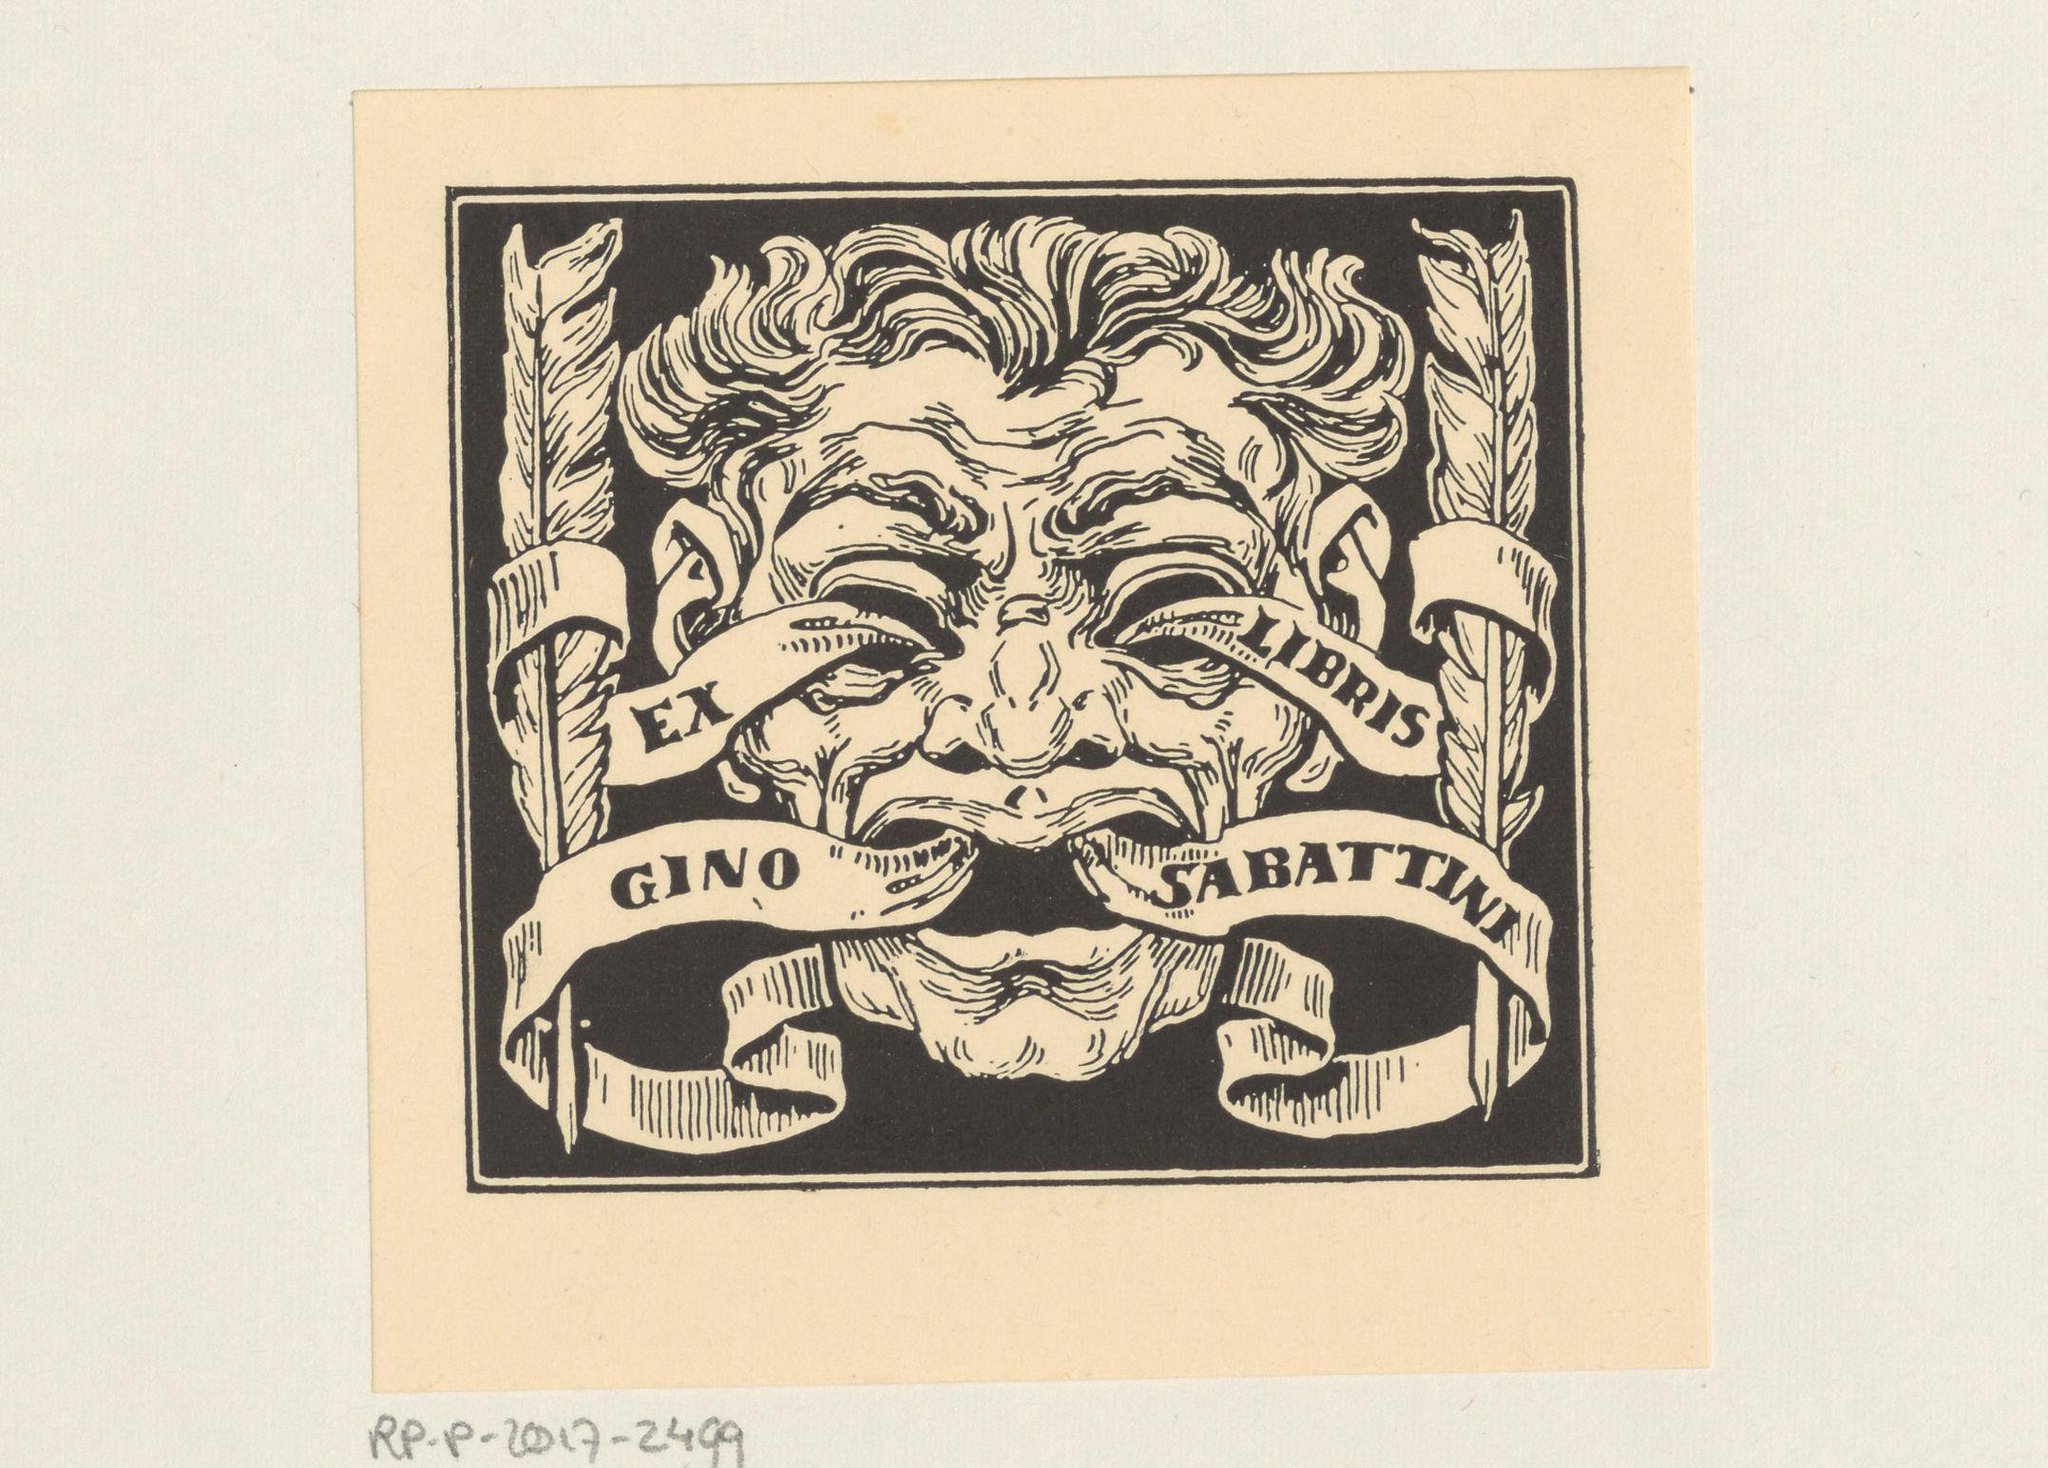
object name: bookplate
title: Ex libris van Gino Sabattini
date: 1920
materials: paper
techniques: printing block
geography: italy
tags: gino sabattini, mask, quill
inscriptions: inscription: ‘G. Ceragioli 1920’